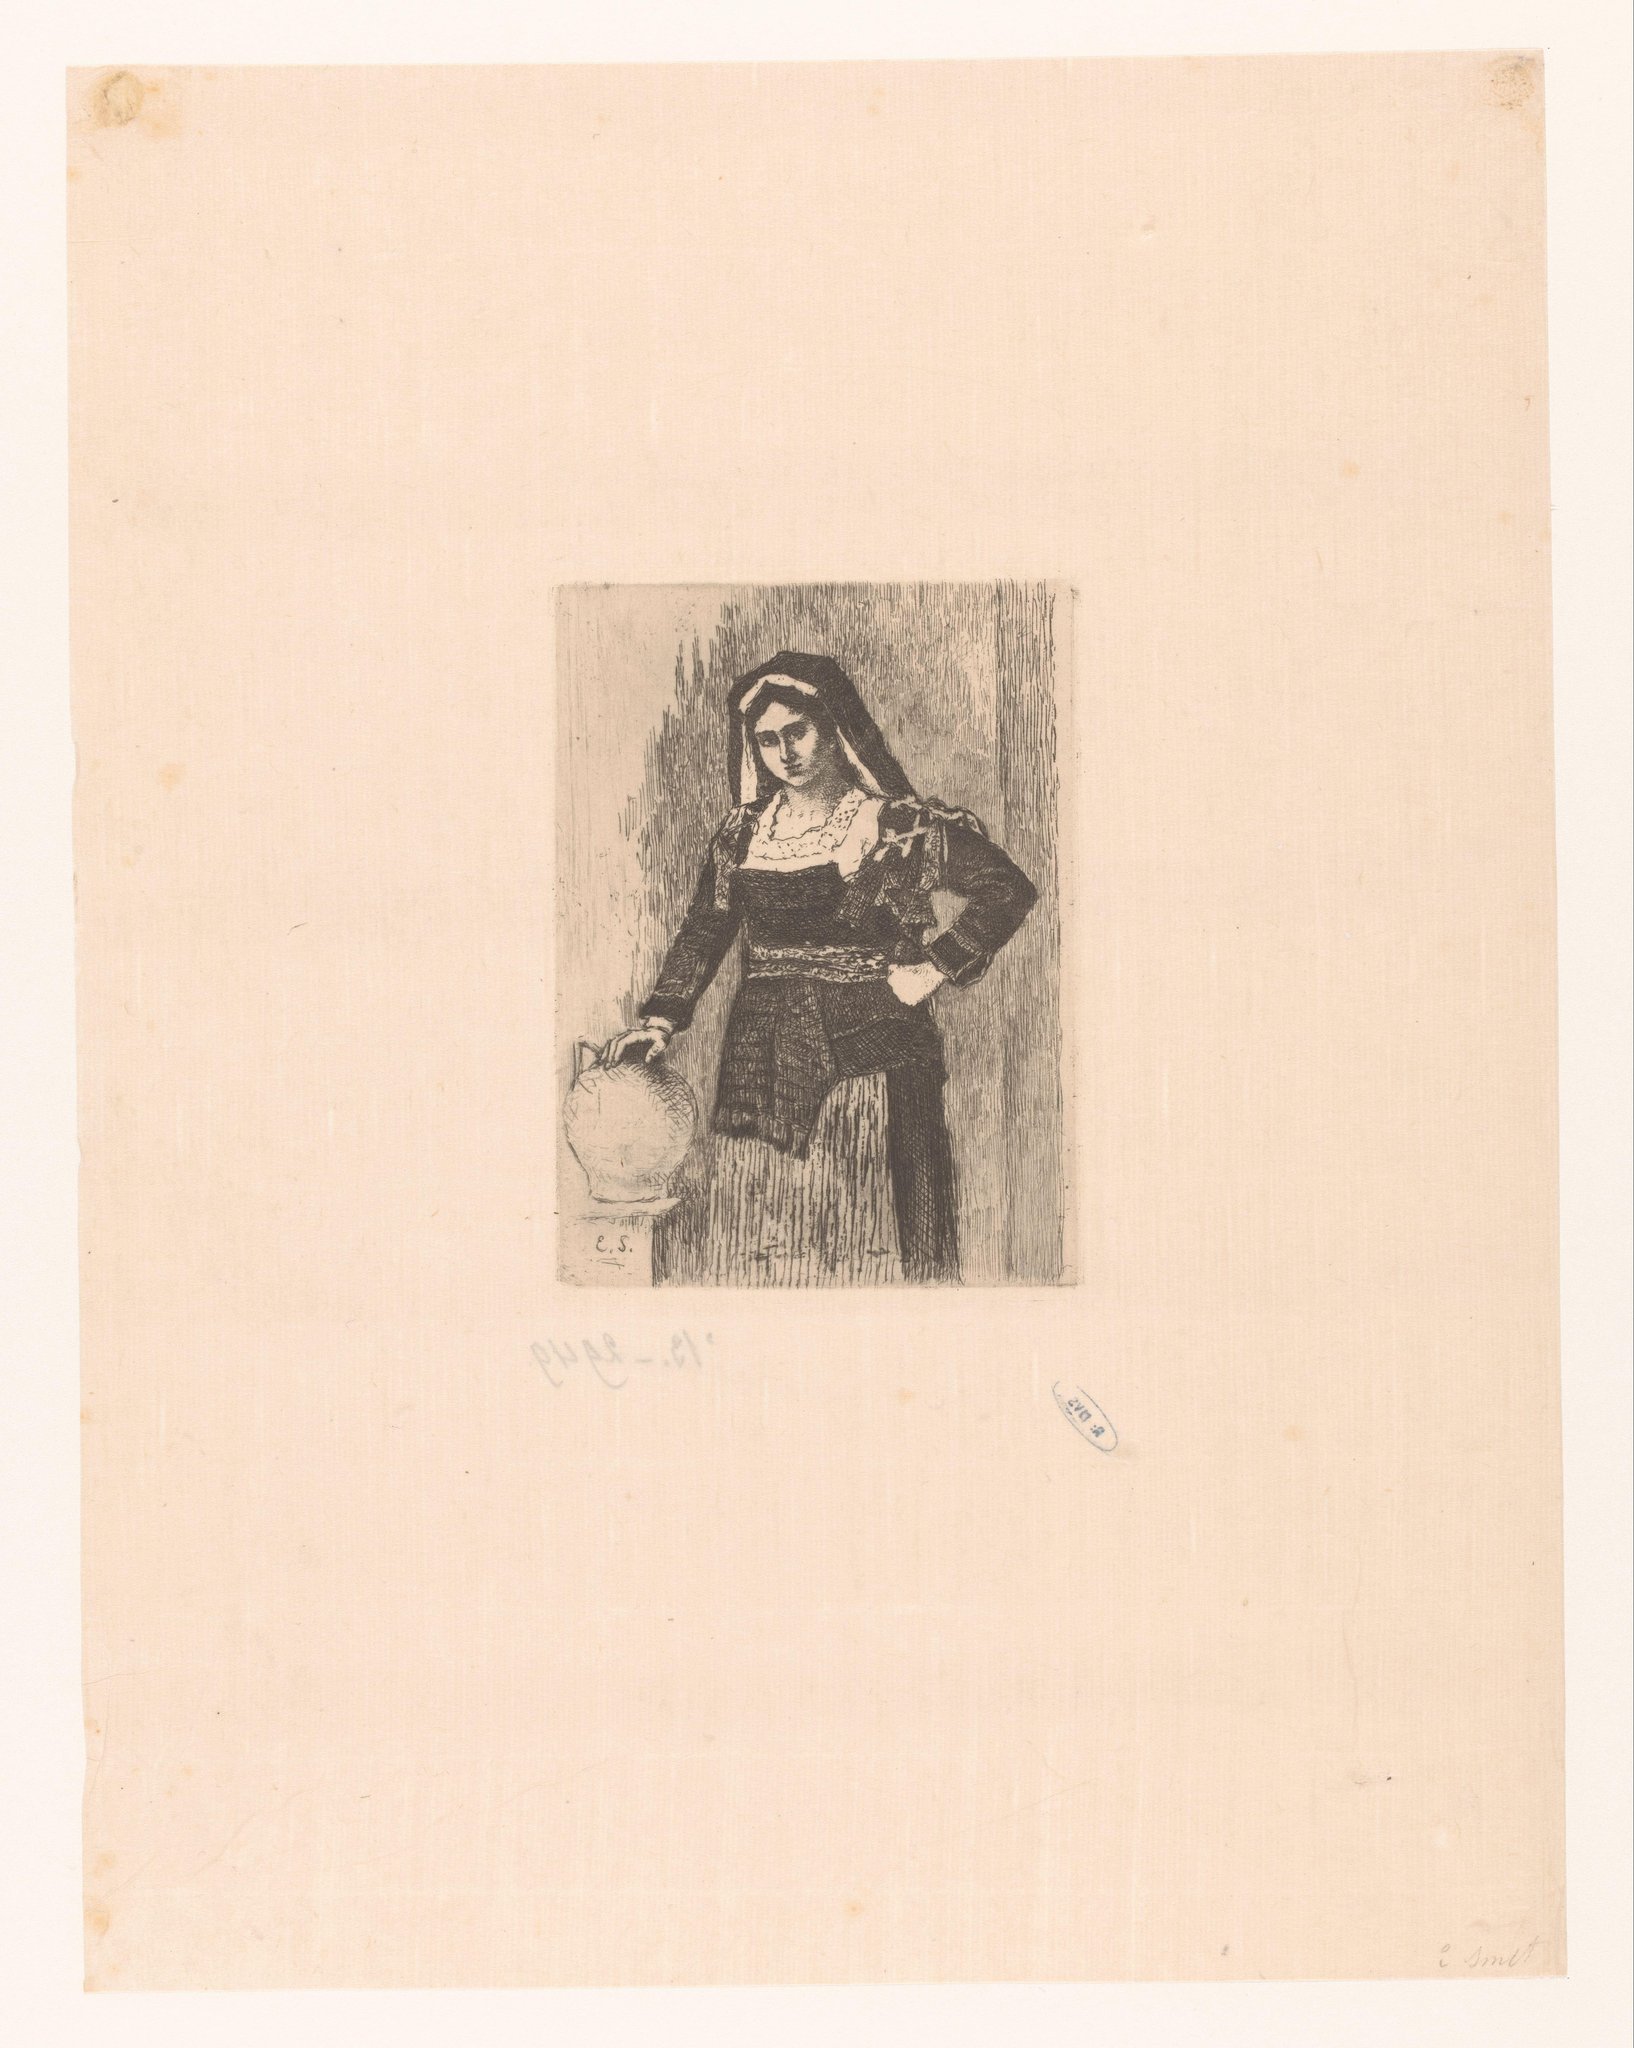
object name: print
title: Italiaanse vrouw leunend op een vaas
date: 1802-1875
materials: paper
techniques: drypoint, etching, intaglio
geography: brussels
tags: anonymous historical person portrayed alone - bb - woman, folk costume, regional costume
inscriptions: collector's mark: Lugt 2228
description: Prent uit de aflevering voor februari van het 'Album d'eaux-fortes originales et inédites'.